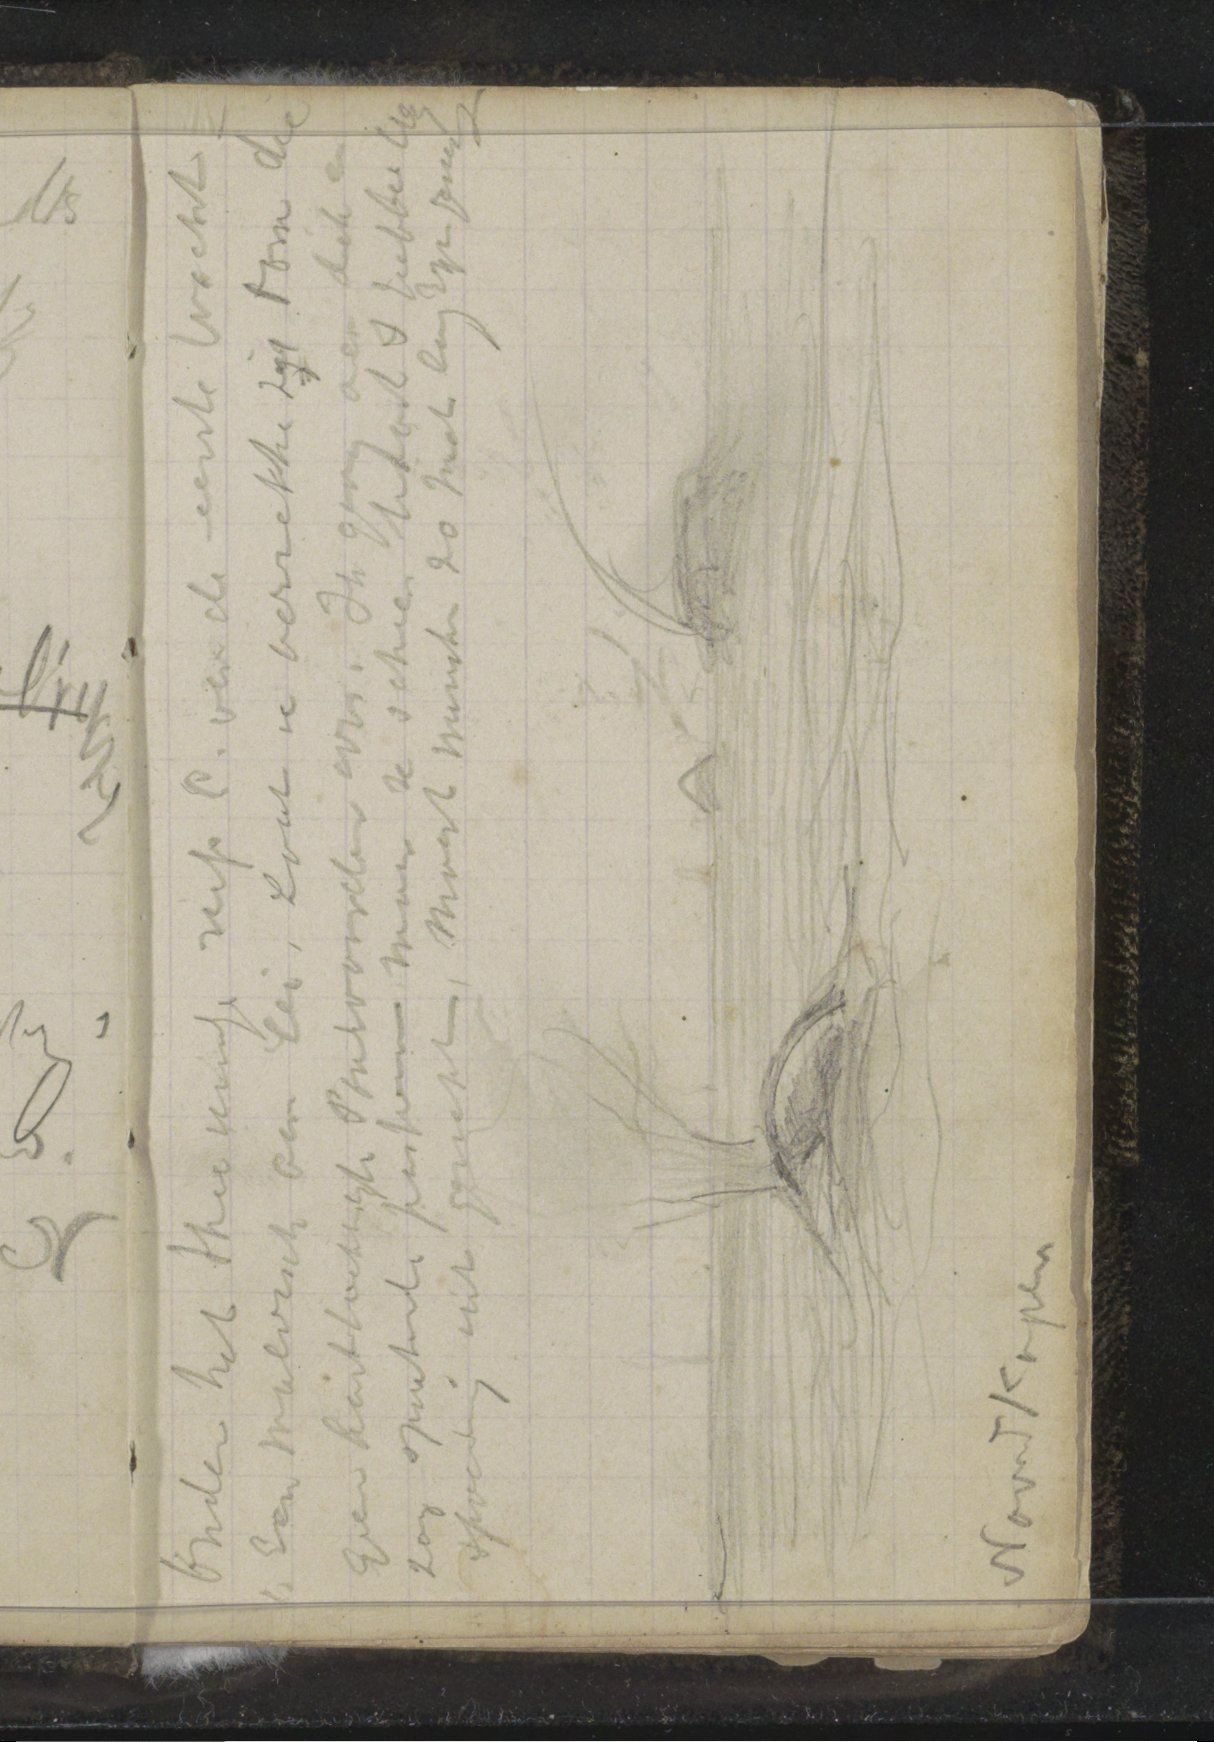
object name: sketchbook leaf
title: Twee spuitende walvissen in de Barentszzee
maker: louis apol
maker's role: draughtsman, painter, print maker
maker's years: 1850-1936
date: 1807-1880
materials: pencil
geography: north cape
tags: sea (seascape), swimming mammals: whale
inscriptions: annotation: ‘Onder het thee kransje[?] riep C. van de eerste wacht / [...] / Noord Kapen’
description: Met een ooggetuigenverslag. Blad 9 recto uit een schetsboek met 110 bladen betekend tijdens de expeditie naar Nova Zembla in 1880.